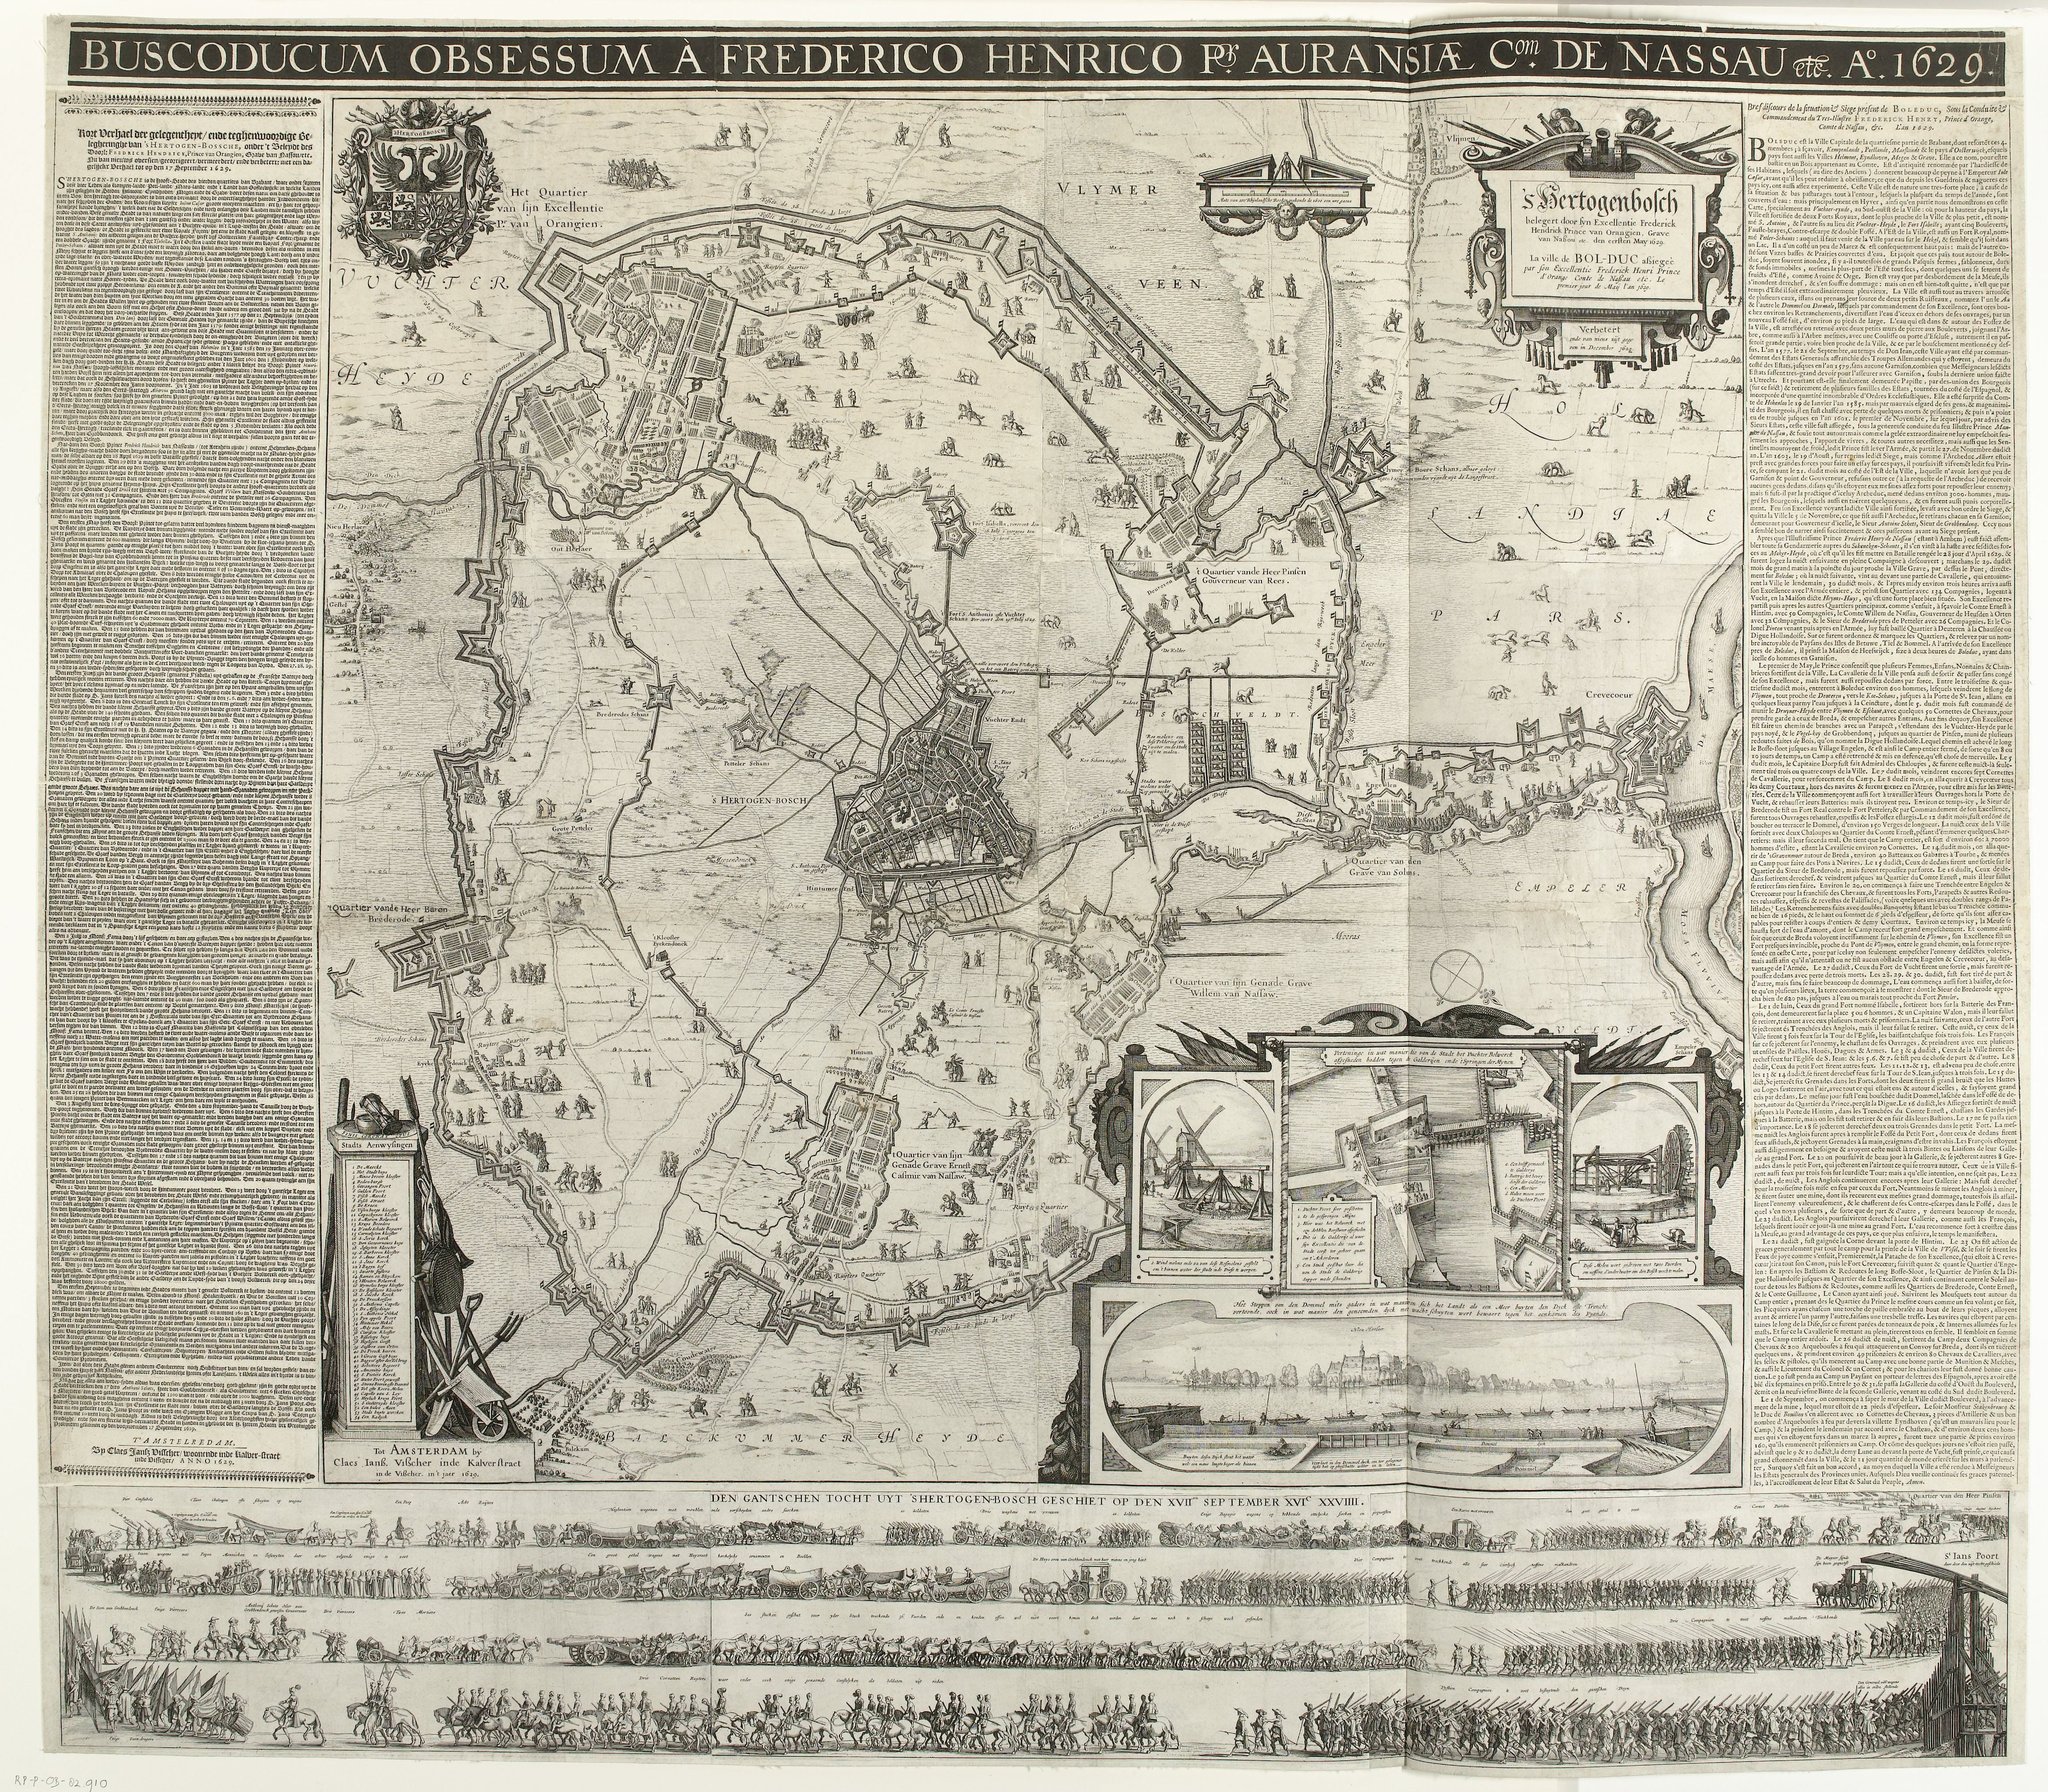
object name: print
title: 's Hertogenbosch belegert door syn Excellentie Frederick Hendrick Prince van Orangien (...) den eersten May 1629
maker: claes jansz. visscher (ii)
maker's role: draughtsman, print maker, publisher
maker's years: 1586-1652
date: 1629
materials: paper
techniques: engraving, etching, letterpress printing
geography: amsterdam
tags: delft, the hague, frederick henry (prince of orange), maps of separate countries or regions, siege, position war, den bosch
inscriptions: date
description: Grote kaart van het beleg van Den Bosch door het Staatse leger onder Frederik Hendrik, van 1 mei tot 17 september 1629. Kaart met centraal de versterkte stad. Rechtsonder voorstellingen van molens, fortificaties en een gezicht op de afsluiting van de Dommel bij Nieu Herlaer. Rechtsboven een cartouche met de titels. Vastgeplakt onderaan een voorstelling in drie platen van de uittocht van het Spaanse garnizoen uit 's-Hertogenbosch. Links en rechts aangeplakte teksten met de beschrijving van de gebeurtenissen in het Nederlands en Frans.